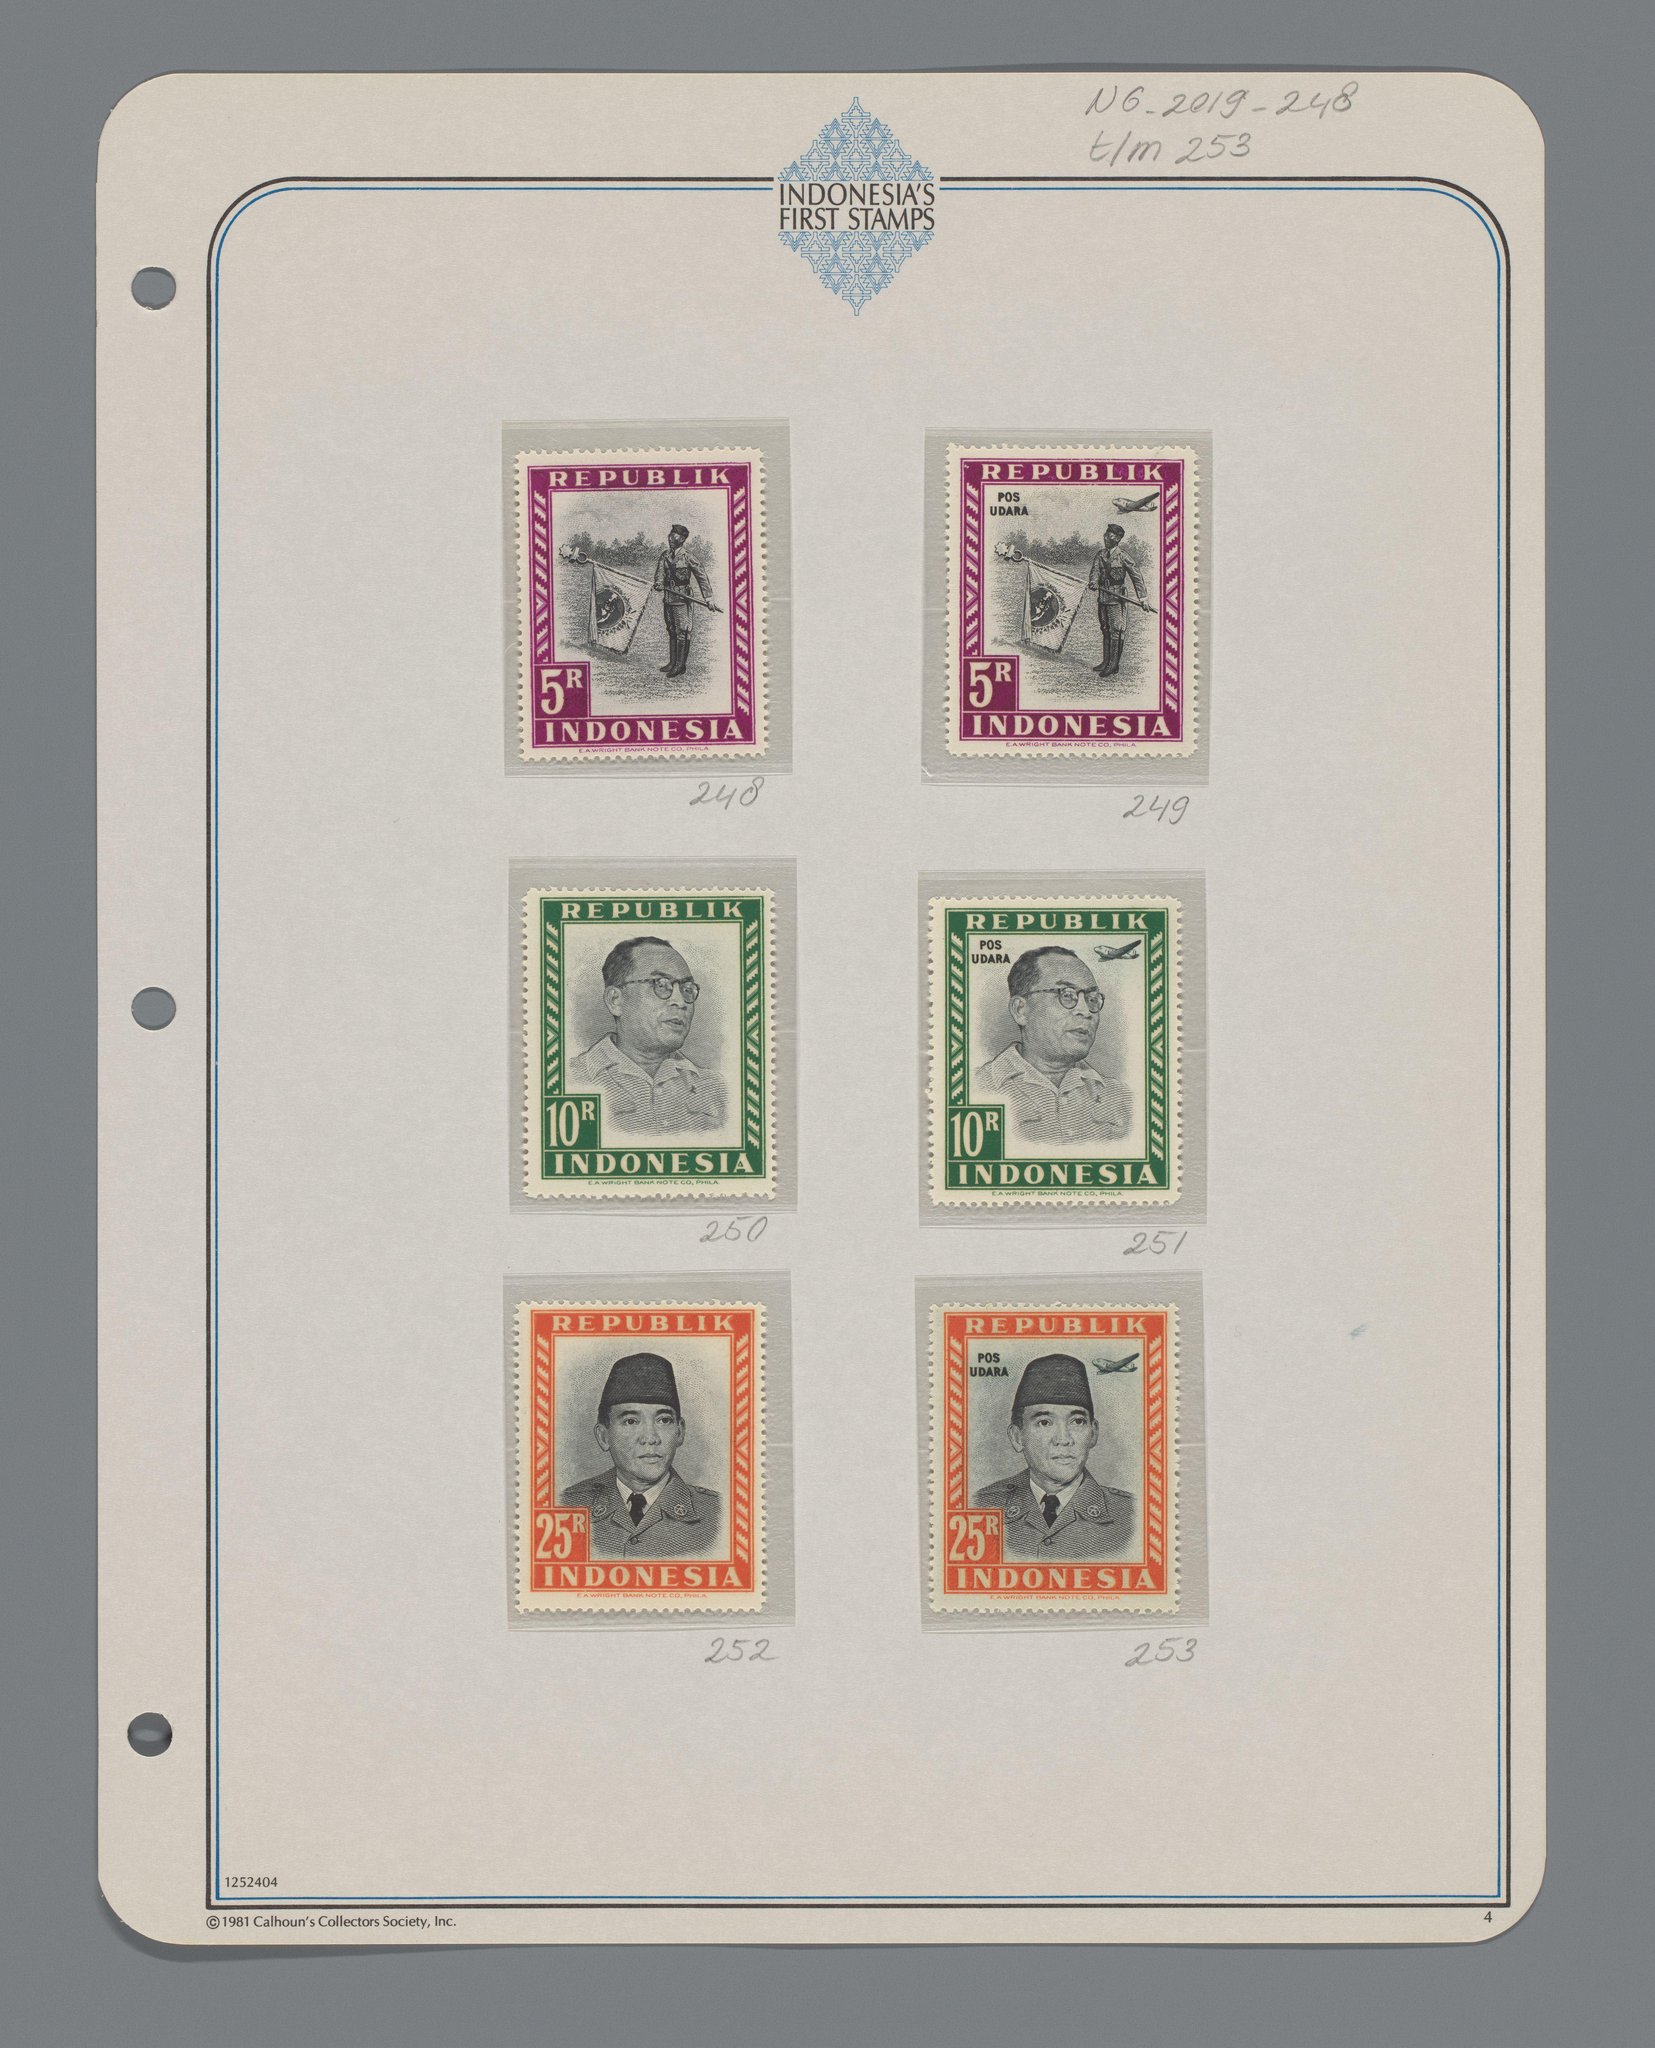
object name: postage stamp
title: Postzegel Republik Indonesia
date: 1949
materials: paper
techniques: photoaquatint, engraving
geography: philadelphia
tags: indonesia